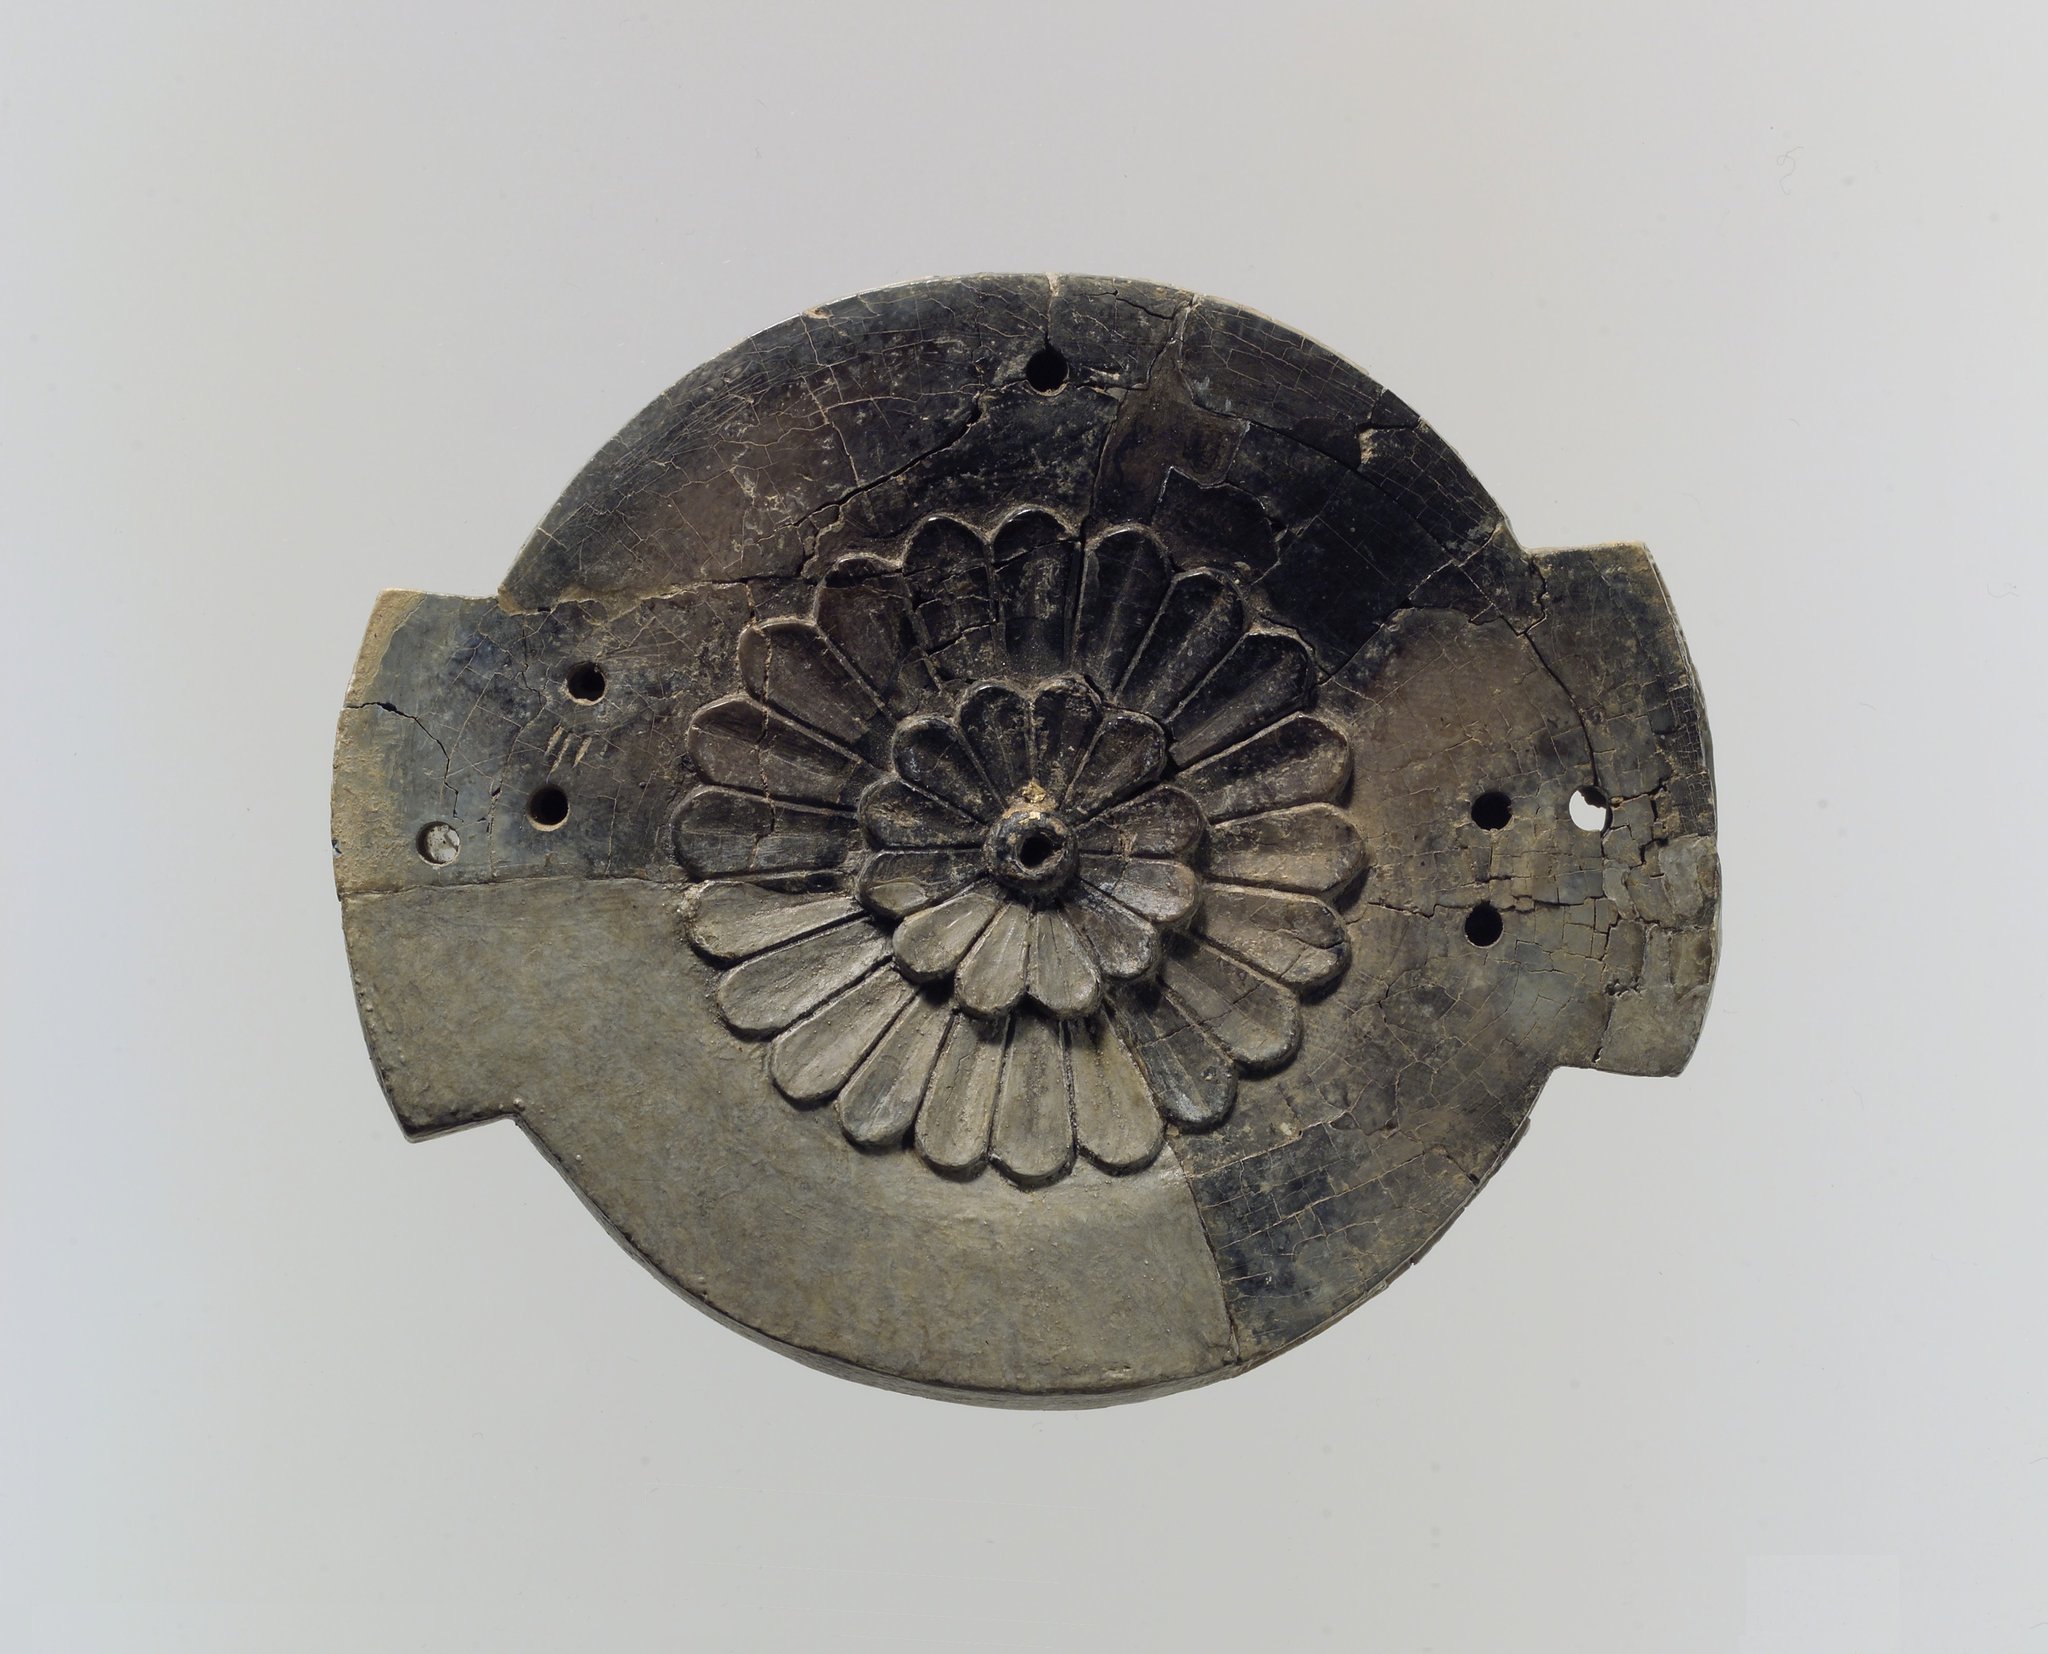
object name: lid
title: Lid fragment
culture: assyrian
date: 900-701 BCE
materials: ivory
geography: mesopotamia